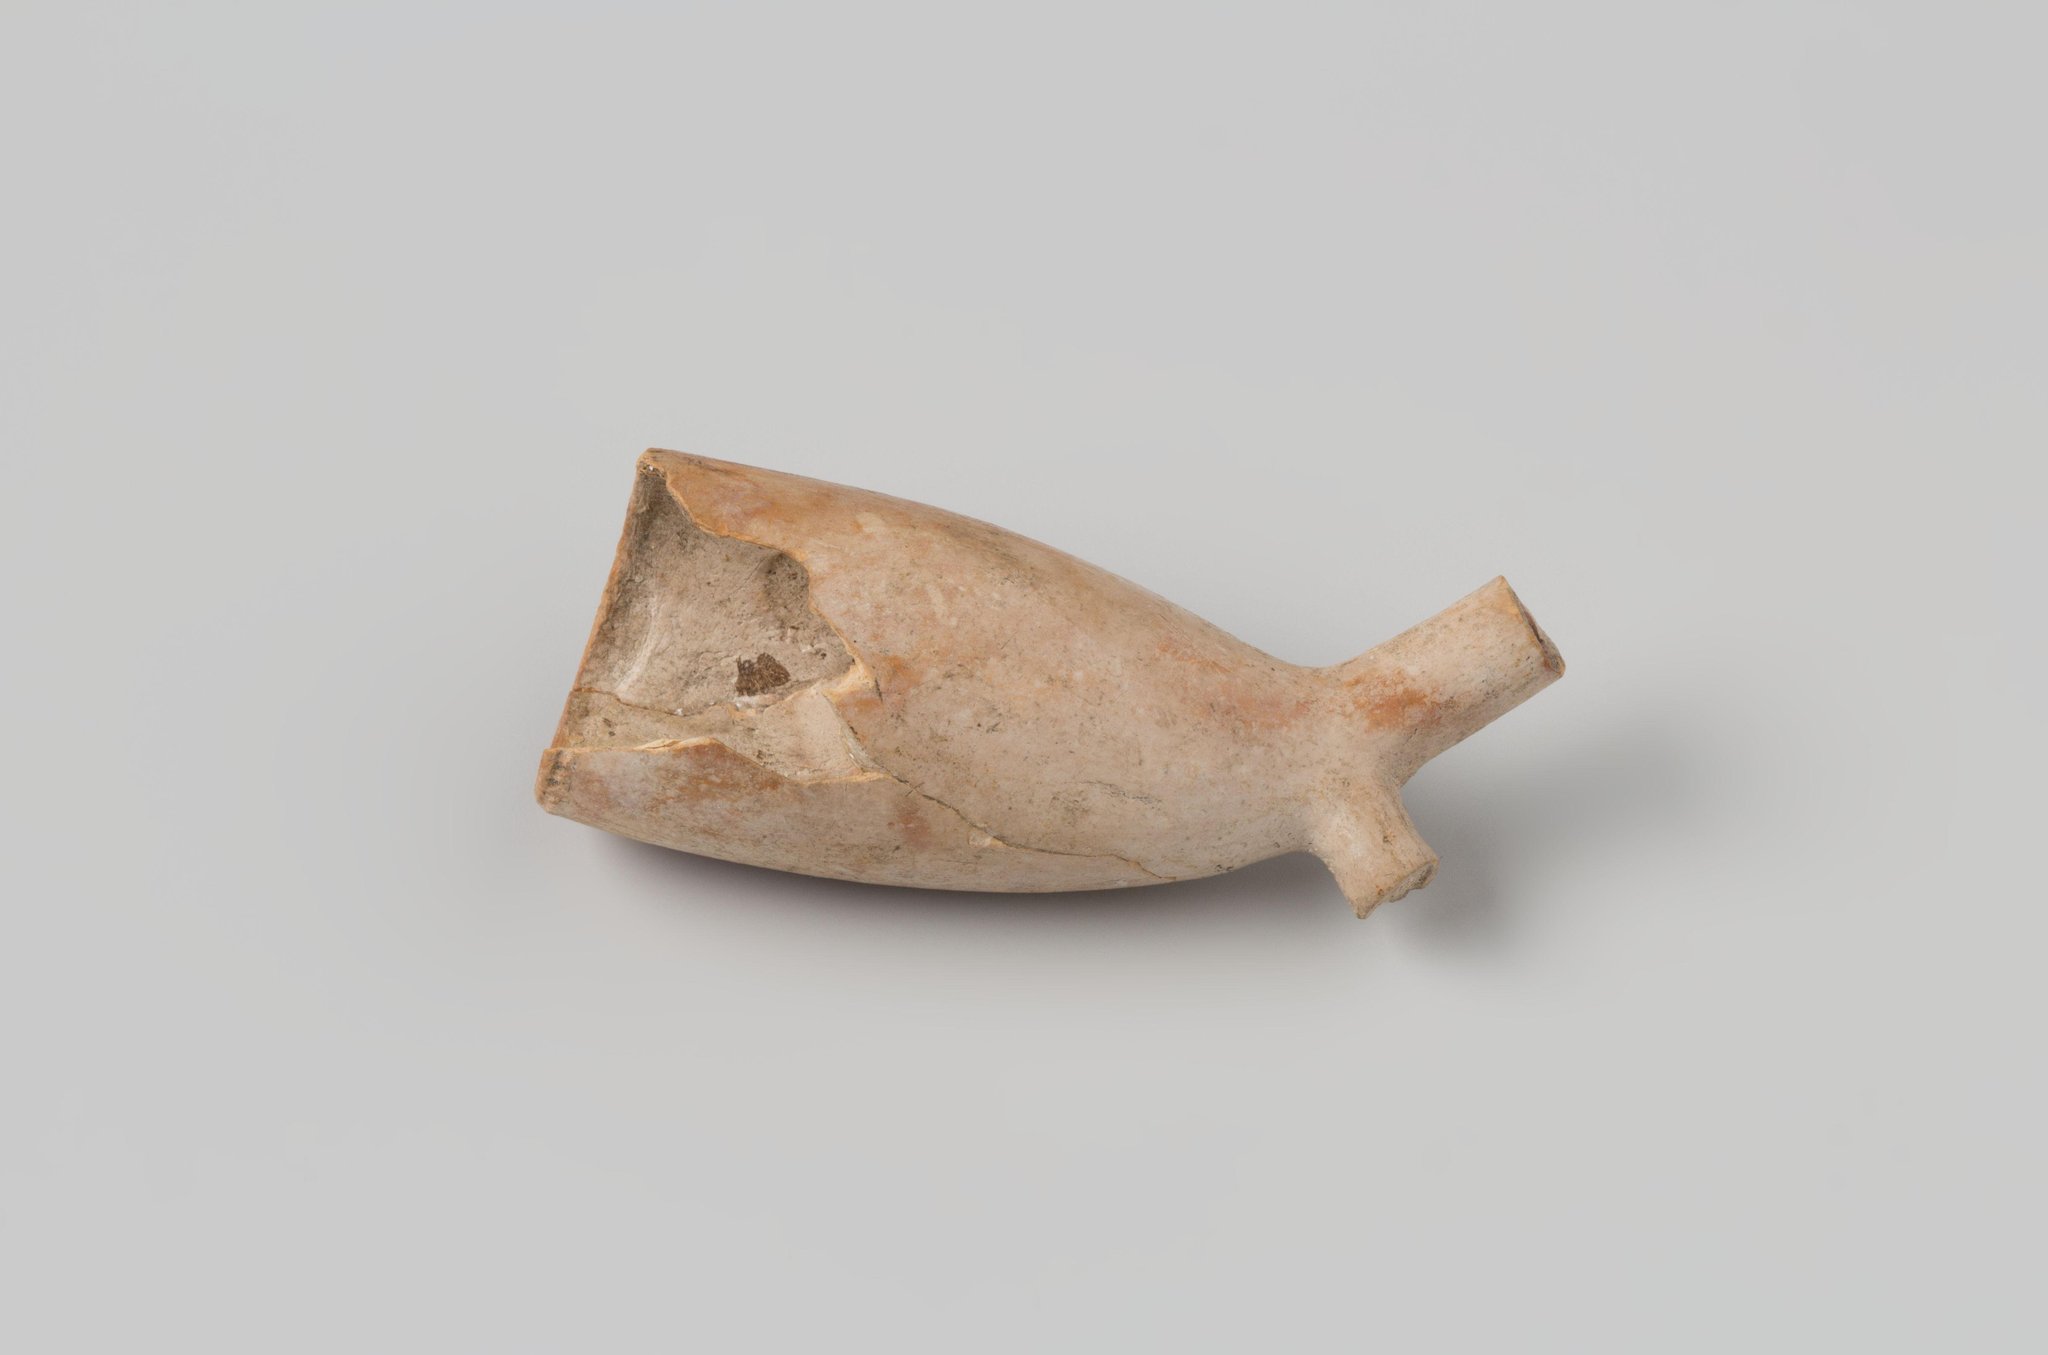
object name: pipe bowl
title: Fragment pijpenkop uit het wrak van de Oost-Indiëvaarder Hollandia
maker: Anonymous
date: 1700-1743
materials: clay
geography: netherlands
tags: verenigde oostindische compagnie, hollandia (schip), annet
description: Pipe, bowl, heelmark: crowned P; fragm, no hsm.